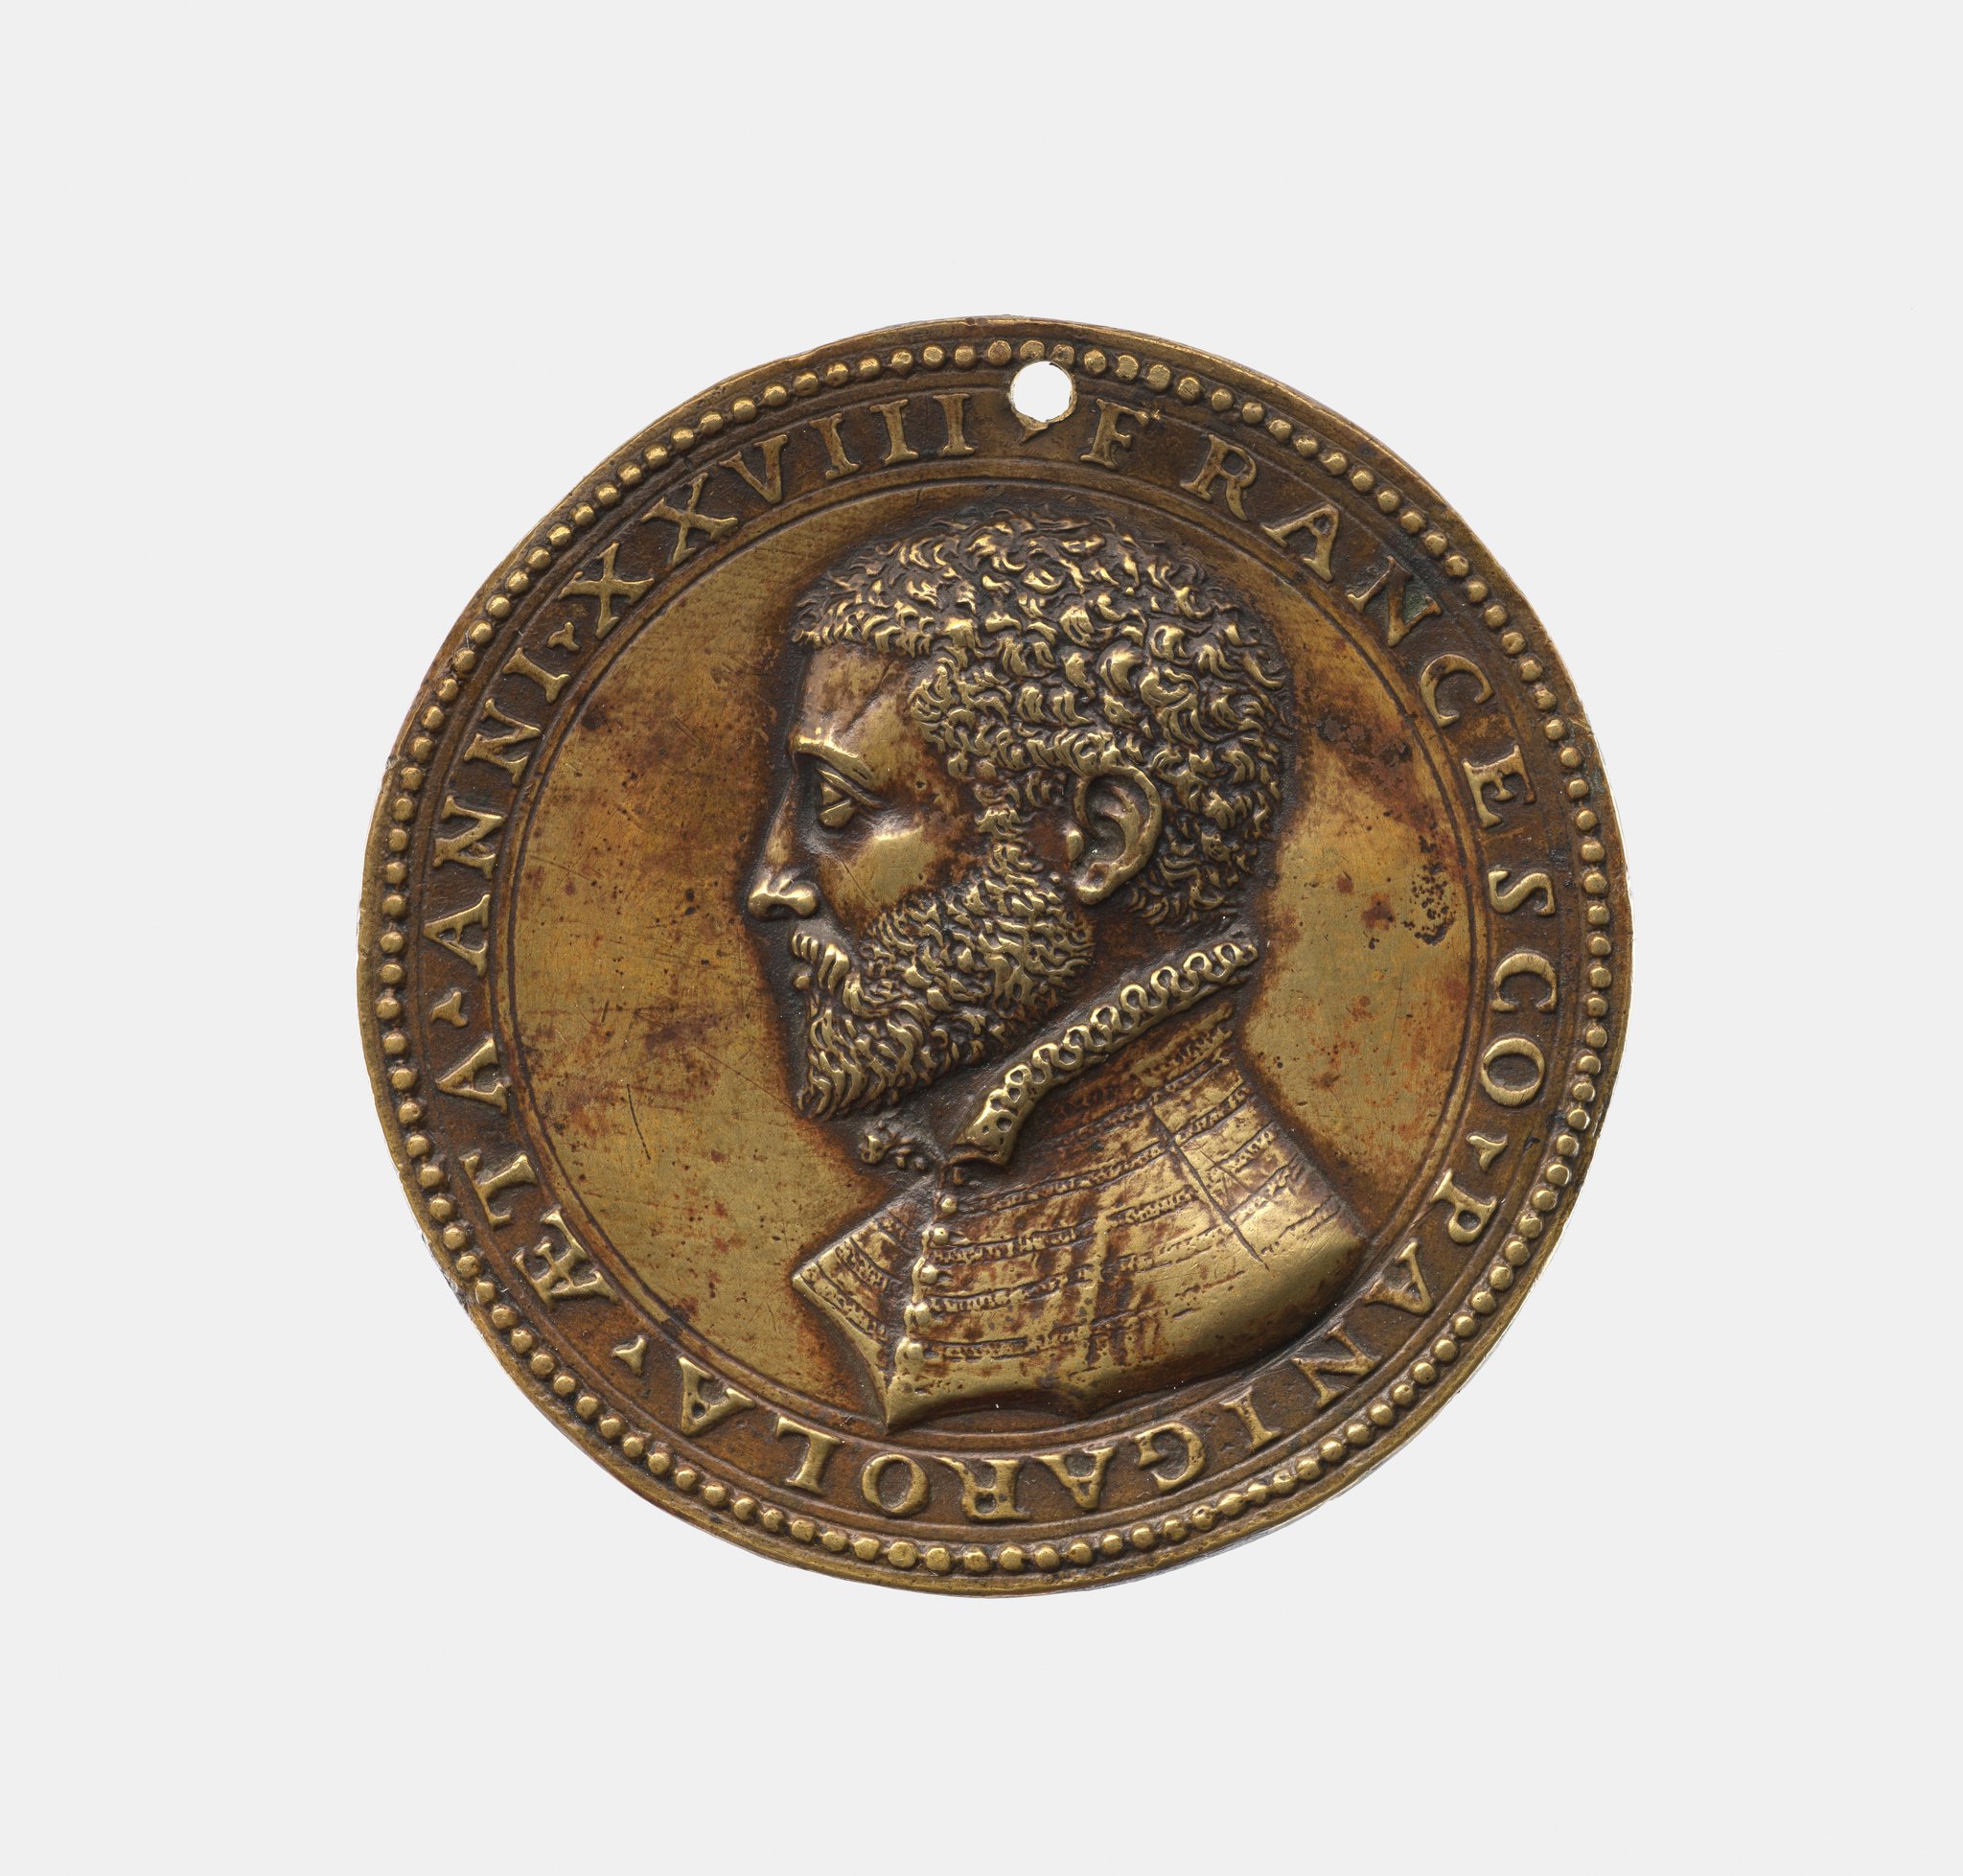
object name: medal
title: Francesco Panigarola 1548-94, Bishop of Asti 1587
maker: Anonymous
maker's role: artist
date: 1576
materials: bronze